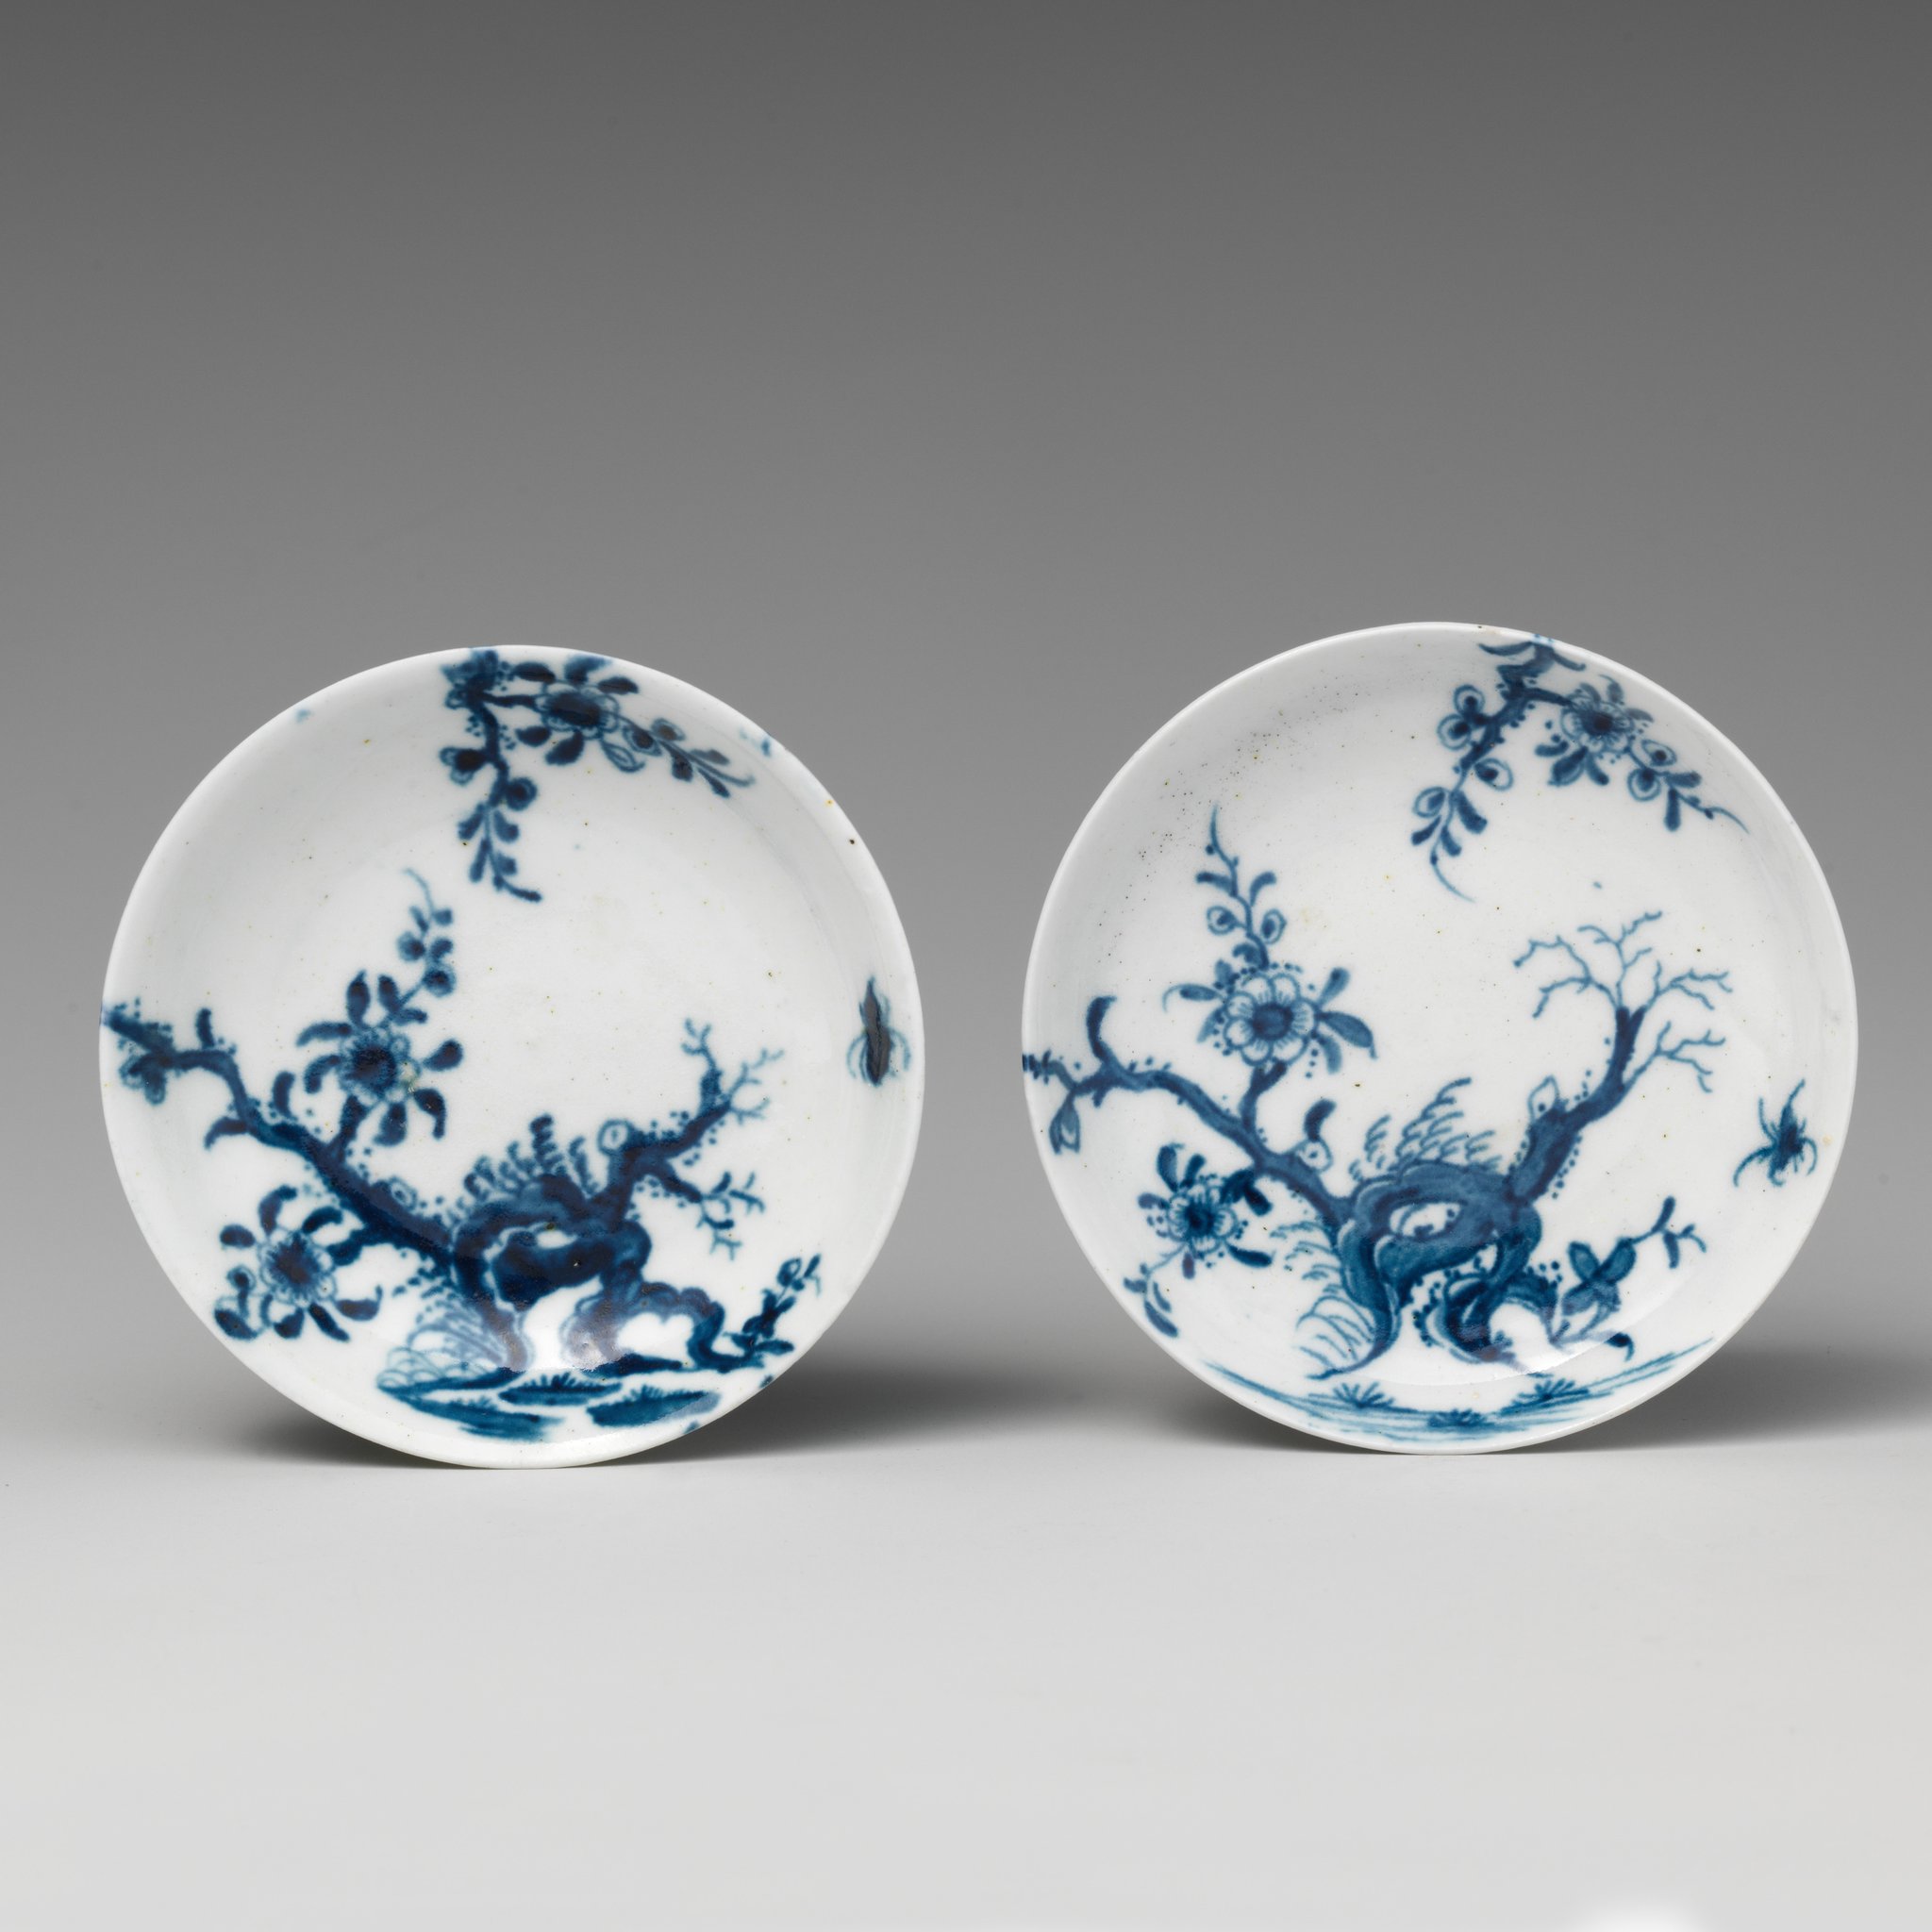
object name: dish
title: Two miniature dishes (part of a service)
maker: worcester factory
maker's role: factory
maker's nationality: british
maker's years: 1751-2008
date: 1760-1762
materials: soft paste porcelain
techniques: underglaze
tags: flowers,trees